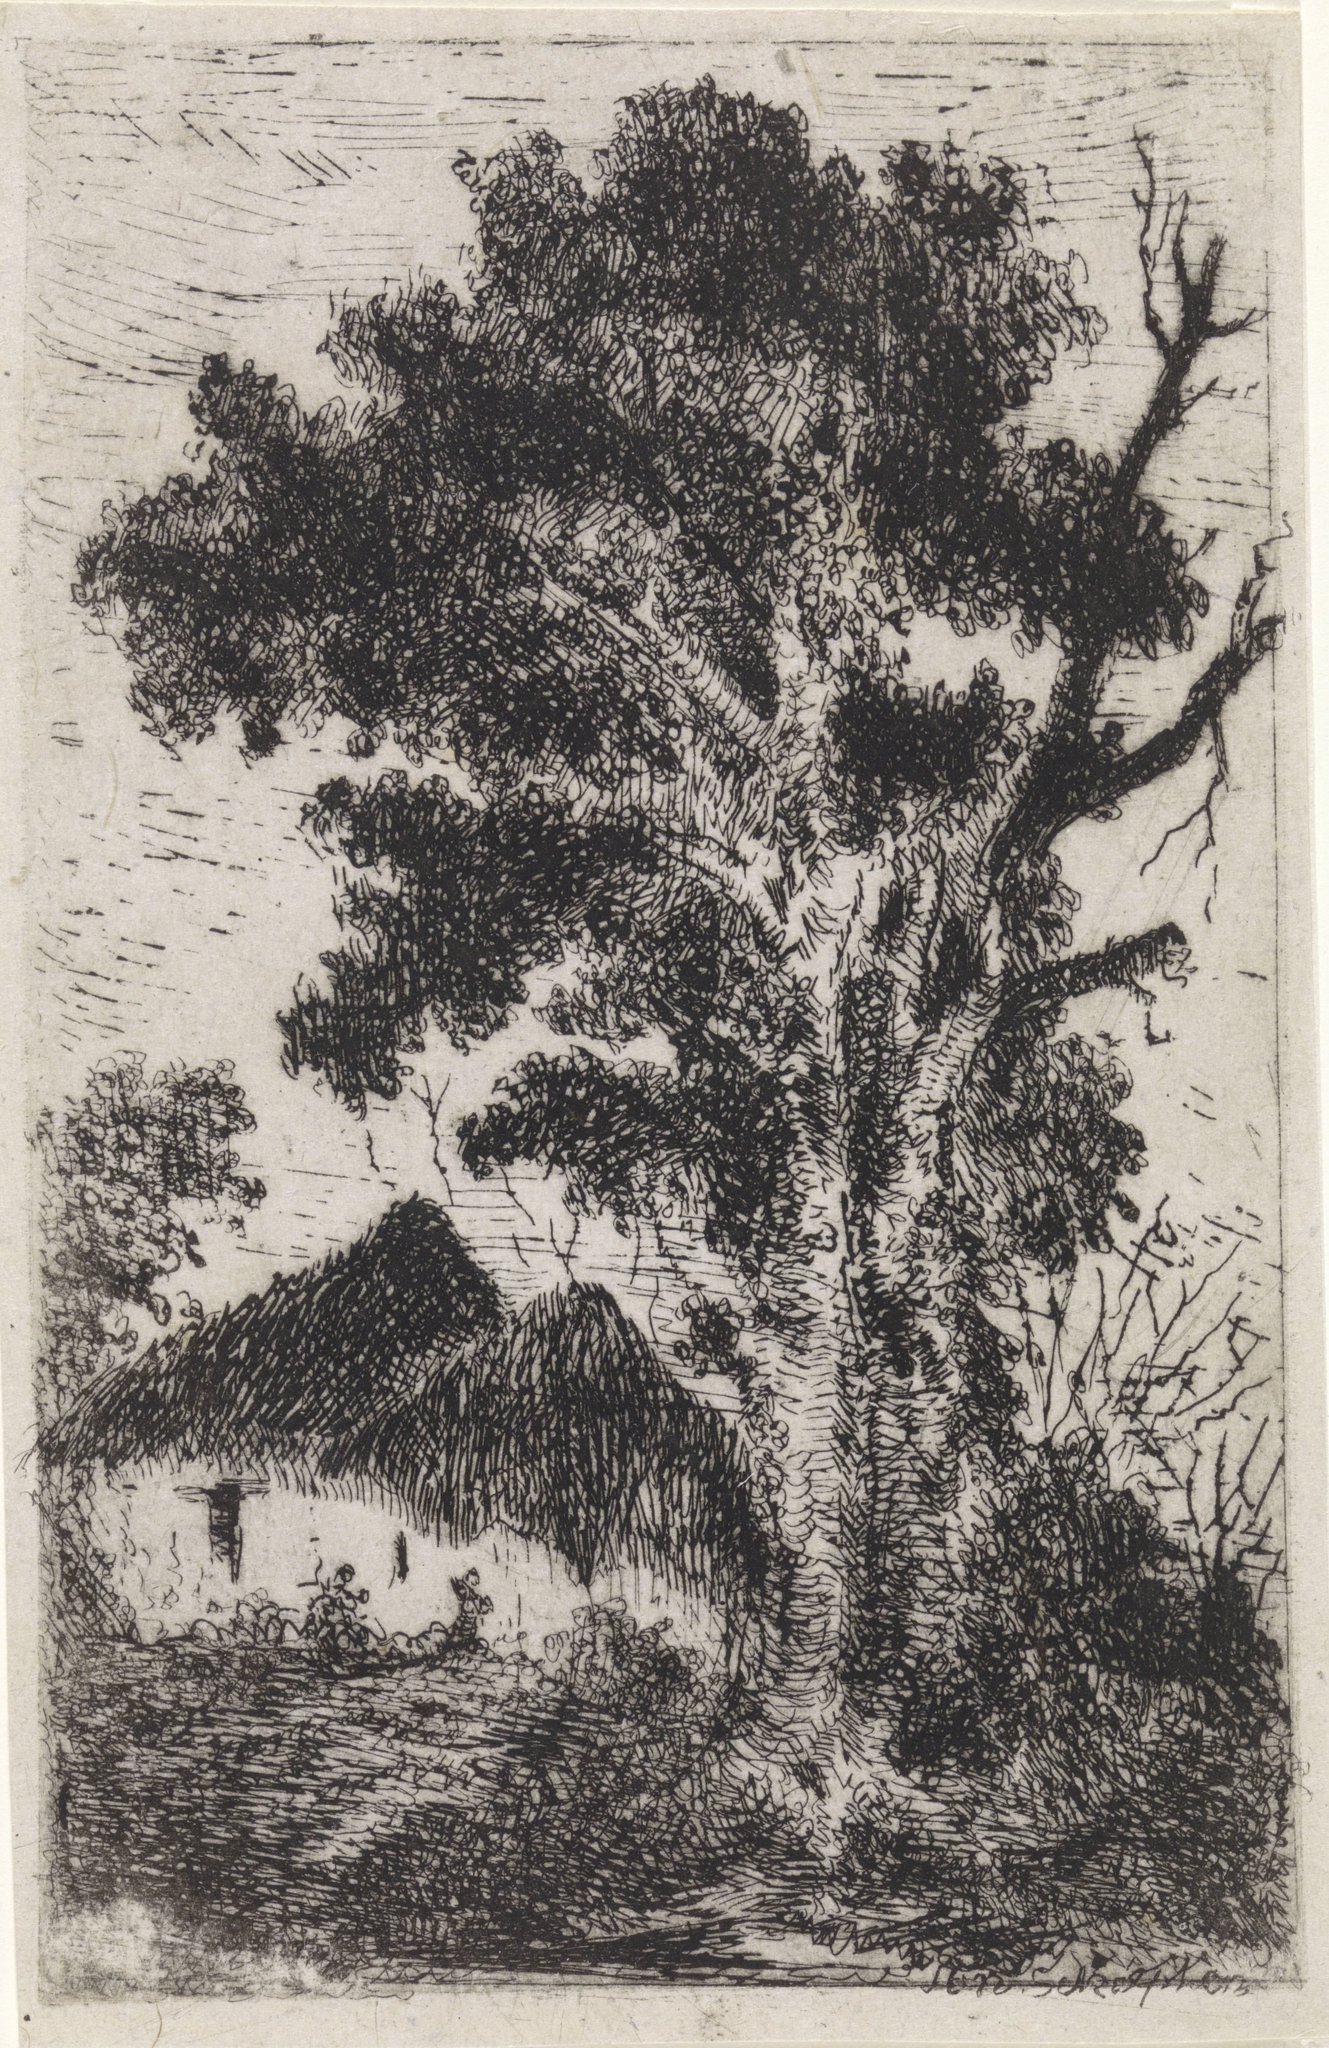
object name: print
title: Rietgedekte hutten onder een grote boom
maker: arnoud schaepkens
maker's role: print maker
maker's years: 1816-1904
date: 1831-1904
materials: paper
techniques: drypoint, etching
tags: landscapes, cottage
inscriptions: collector's mark: Lugt 2228